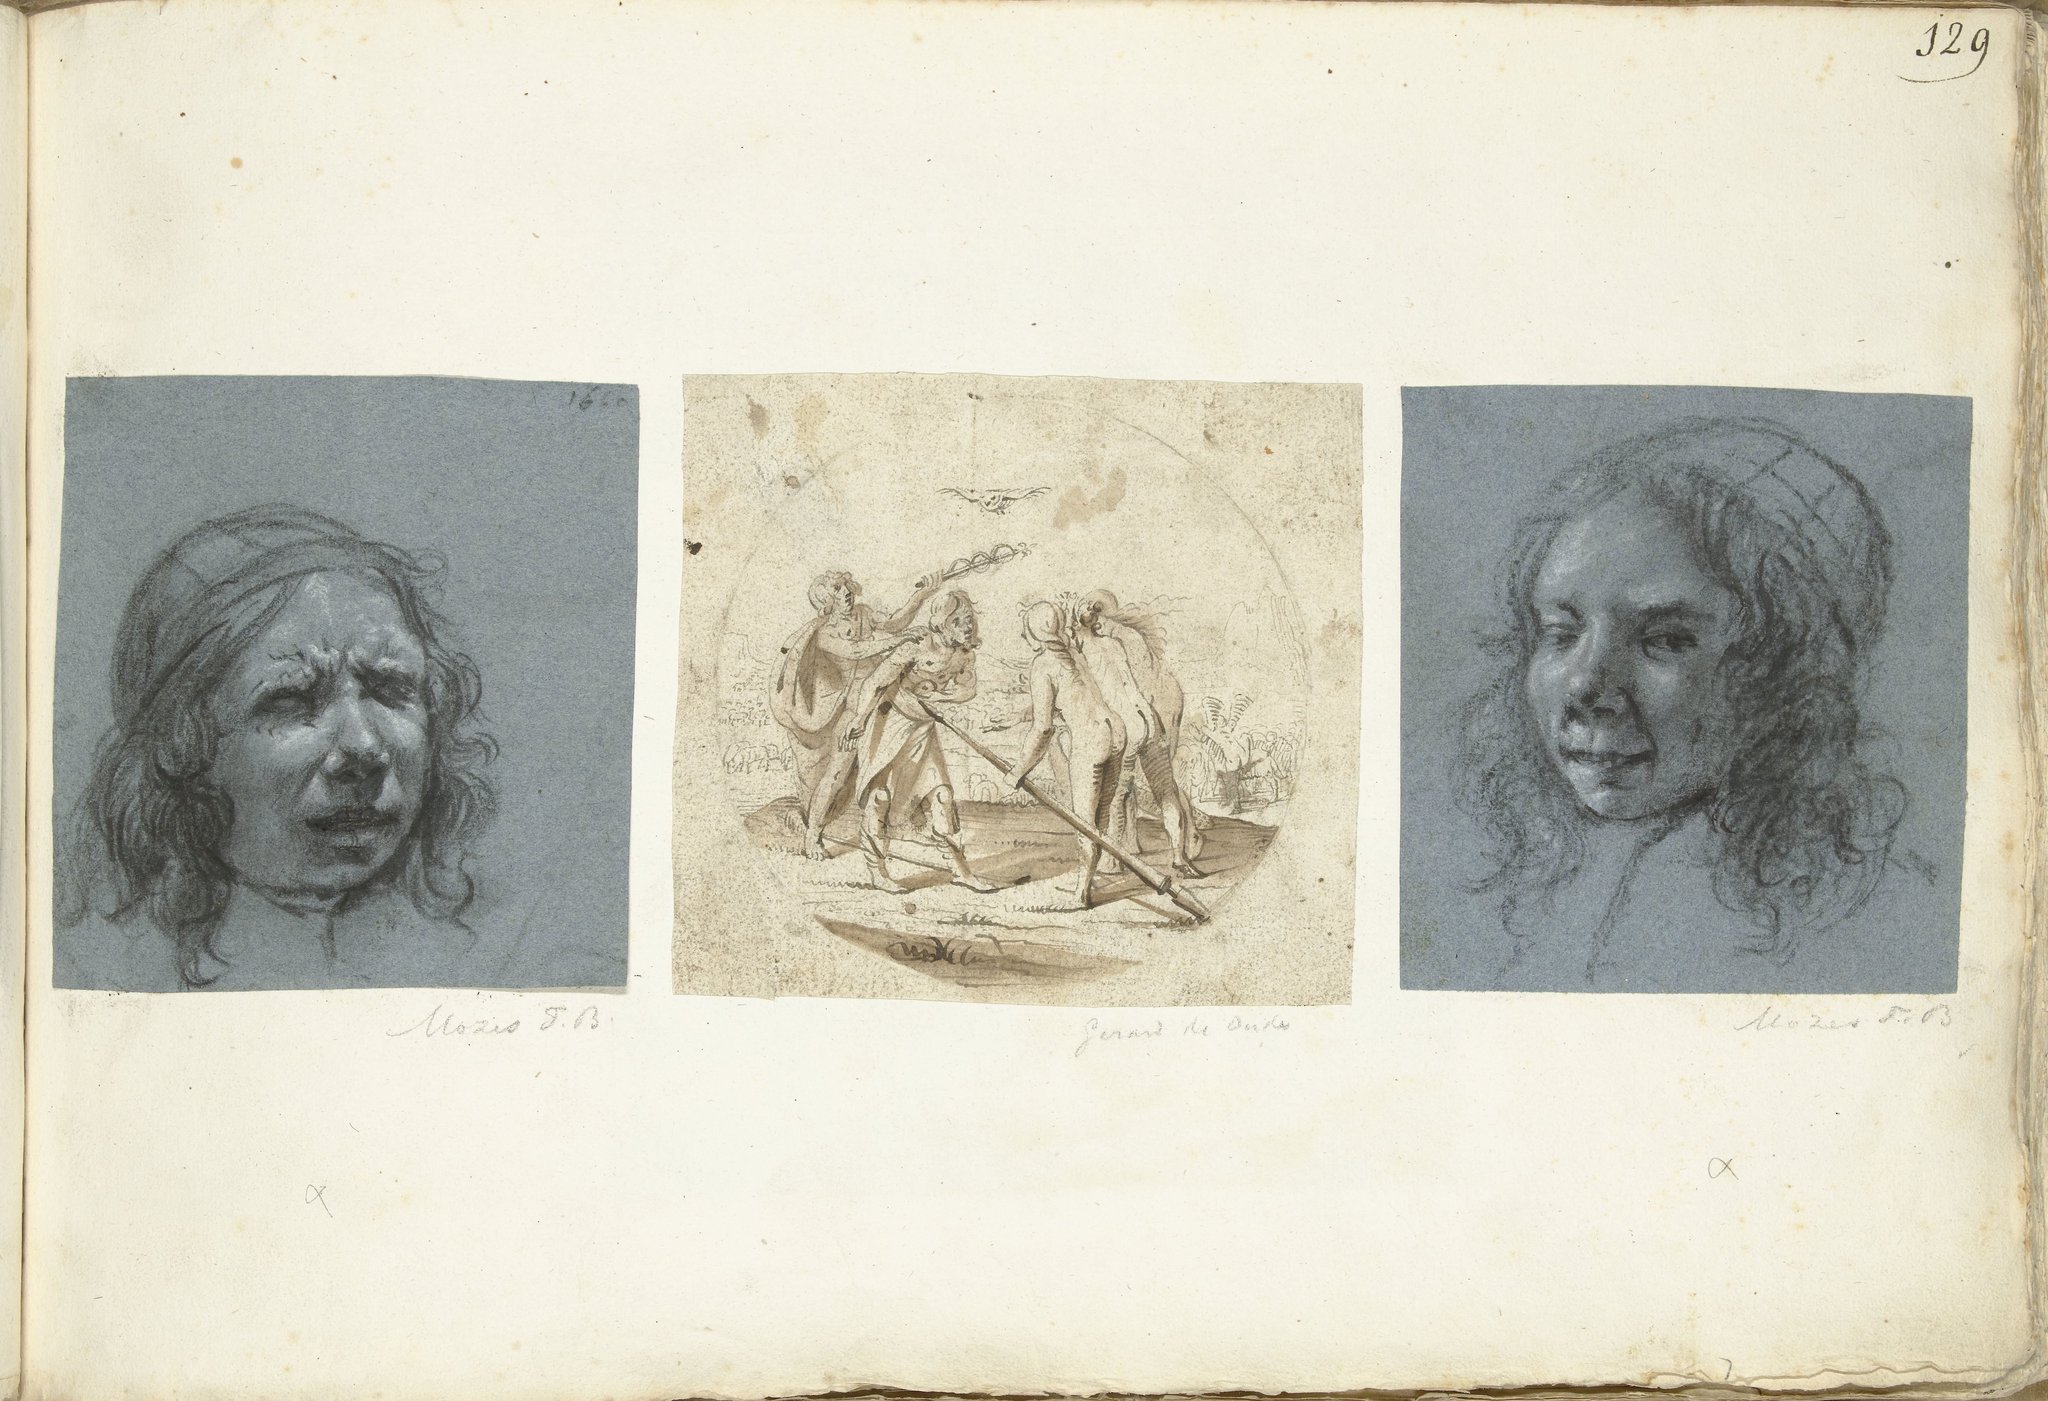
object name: drawing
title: Twee zelfportretten en Het oordeel van Paris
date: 1626-1687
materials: chalk, ink, paper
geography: zwolle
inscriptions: annotation: ‘Mozes T.B.; Gerard de Oude; Mozes T.B.’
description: Tekening met twee andere tekeningen op een blad geplakt.